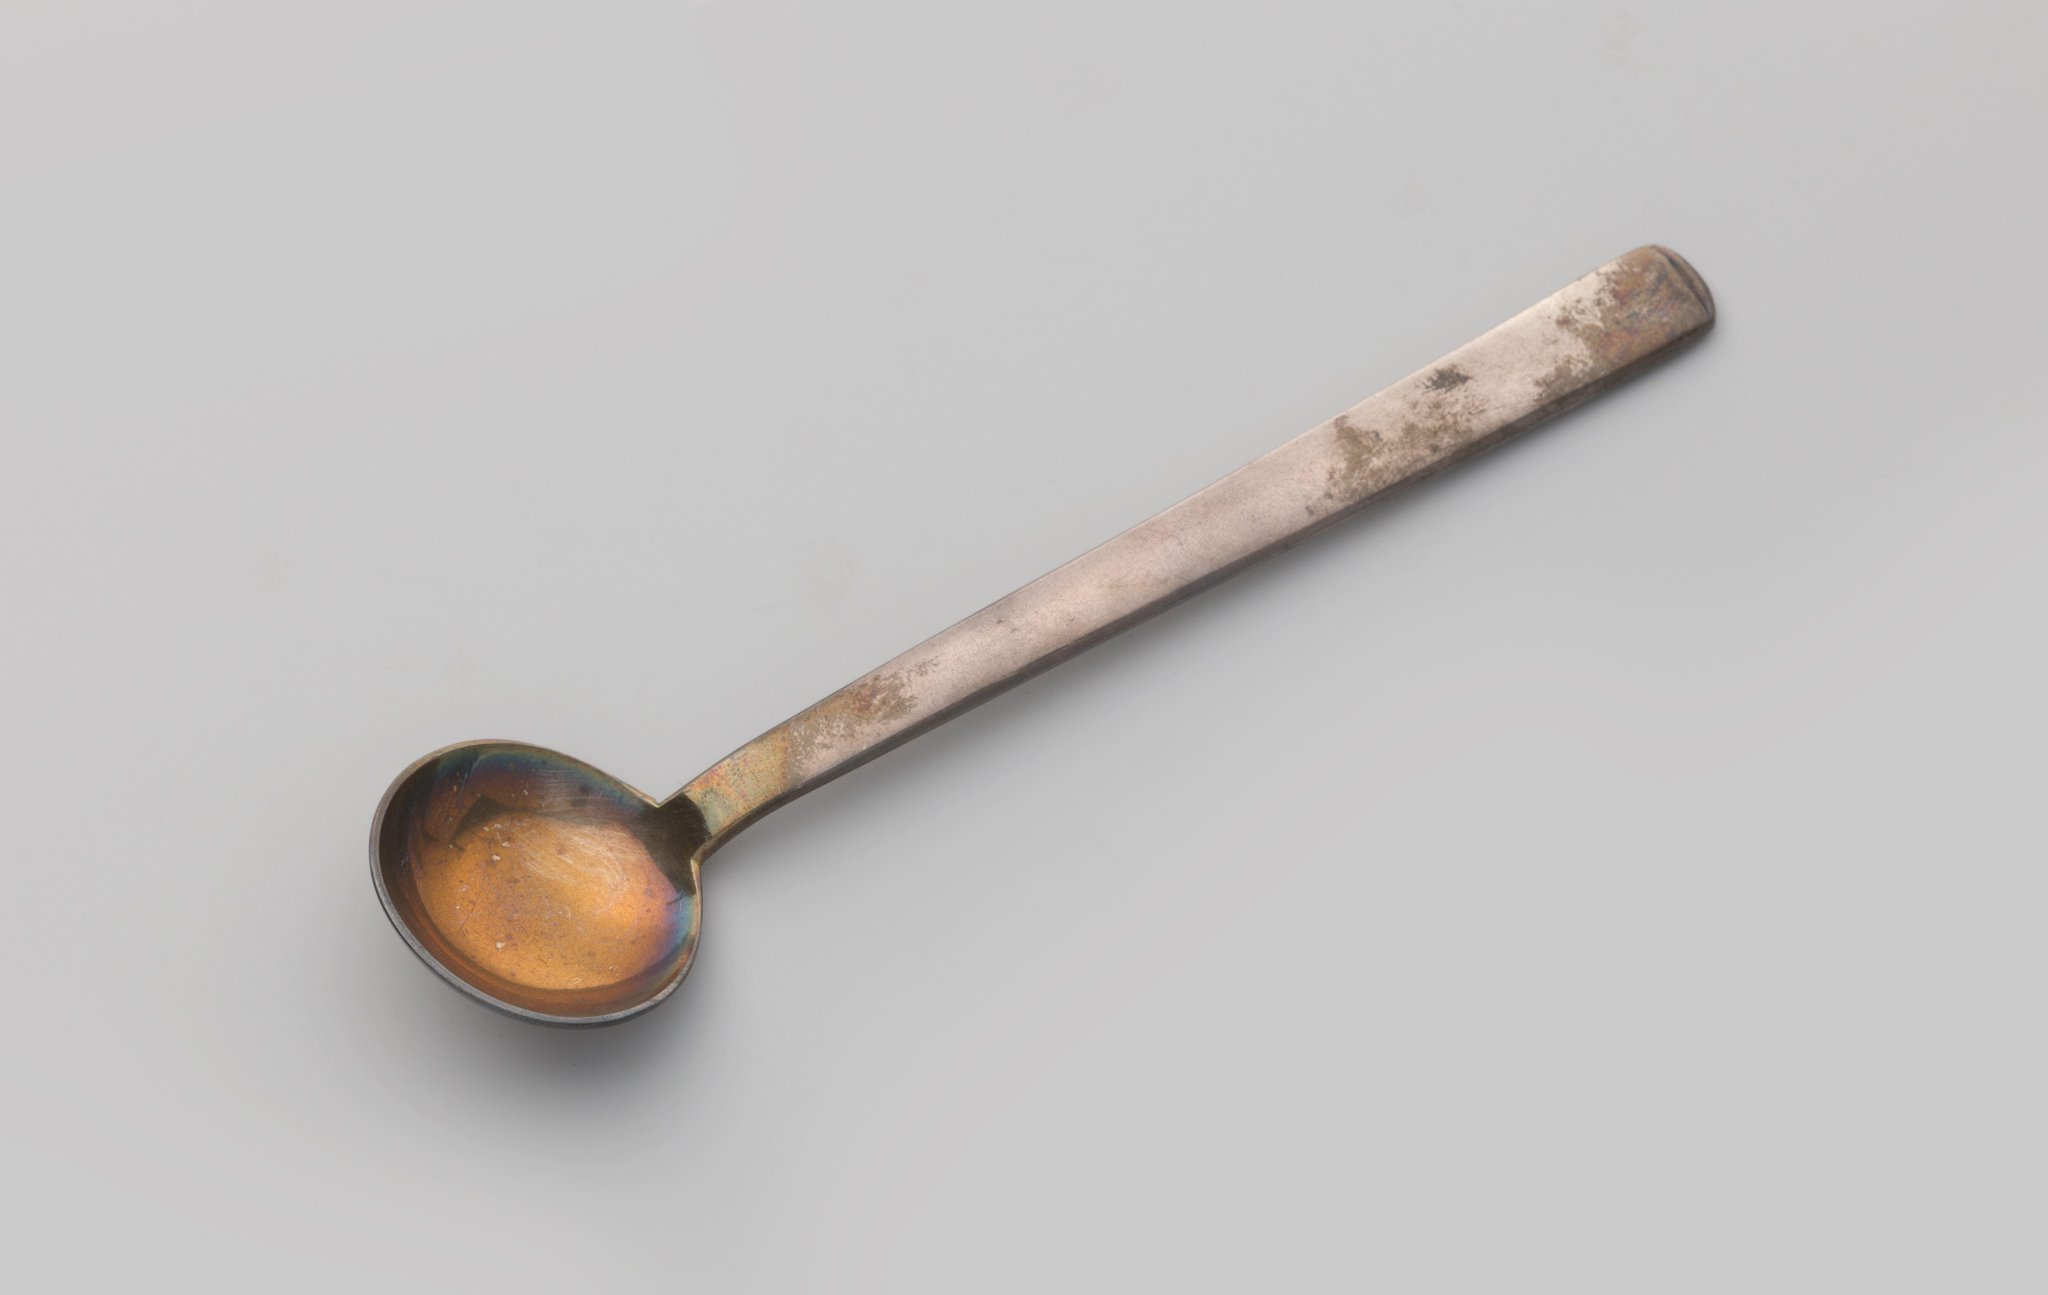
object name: spoon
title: Lepel met ronde bak en zich naar het uiteinde verbredende steel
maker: josef hoffmann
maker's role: designer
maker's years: 1870-1956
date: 1907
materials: alloy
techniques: silvering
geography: vienna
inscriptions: : ‘WW dooreen’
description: Lepel van zilver, met ronde bak. De steel is plat en verbreedt naar het uiteinde toe.